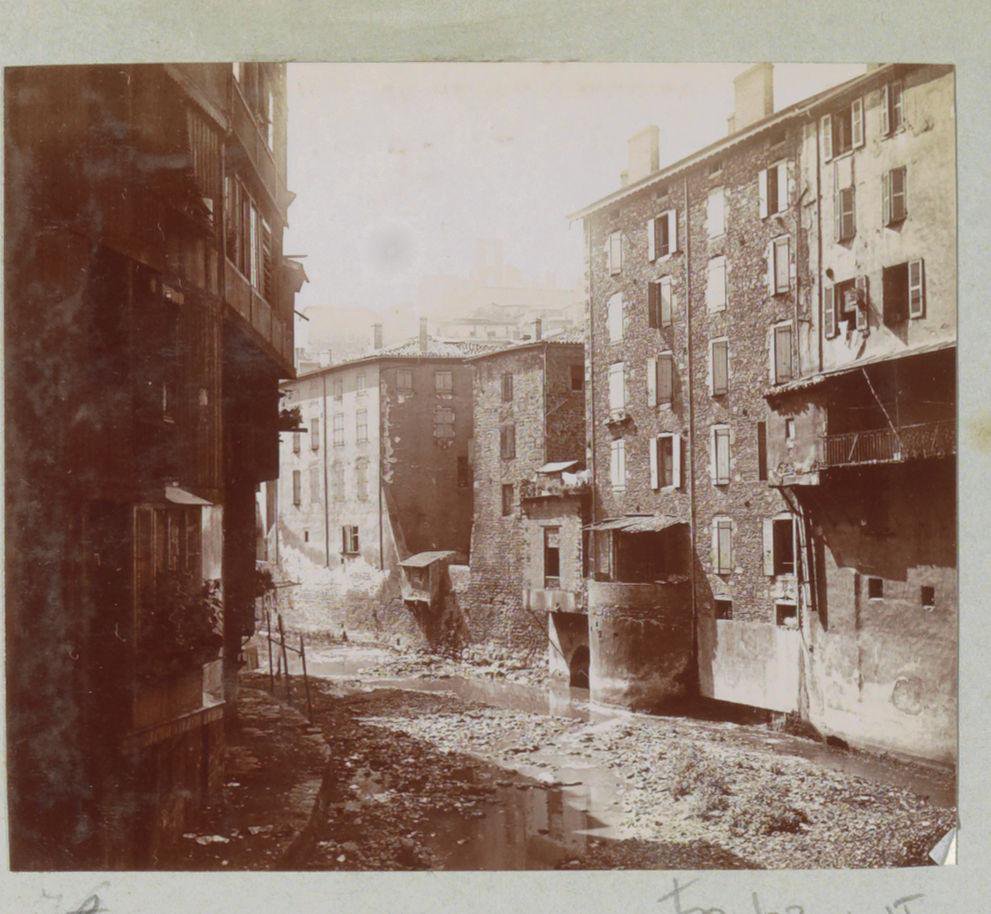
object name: photograph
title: Huizen langs drooggevallen rivierbedding in Annonay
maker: delizy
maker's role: manufacturer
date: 1904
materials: paper, photographic support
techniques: gelatin silver print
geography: annonay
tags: dry river, river bed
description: Onderdeel van Fotoalbum van een Franse amateurfotograaf met opnames van uitstapjes in Frankrijk, Spanje, België, Luxemburg en Nederland, de eerste automobielen en autoraces.